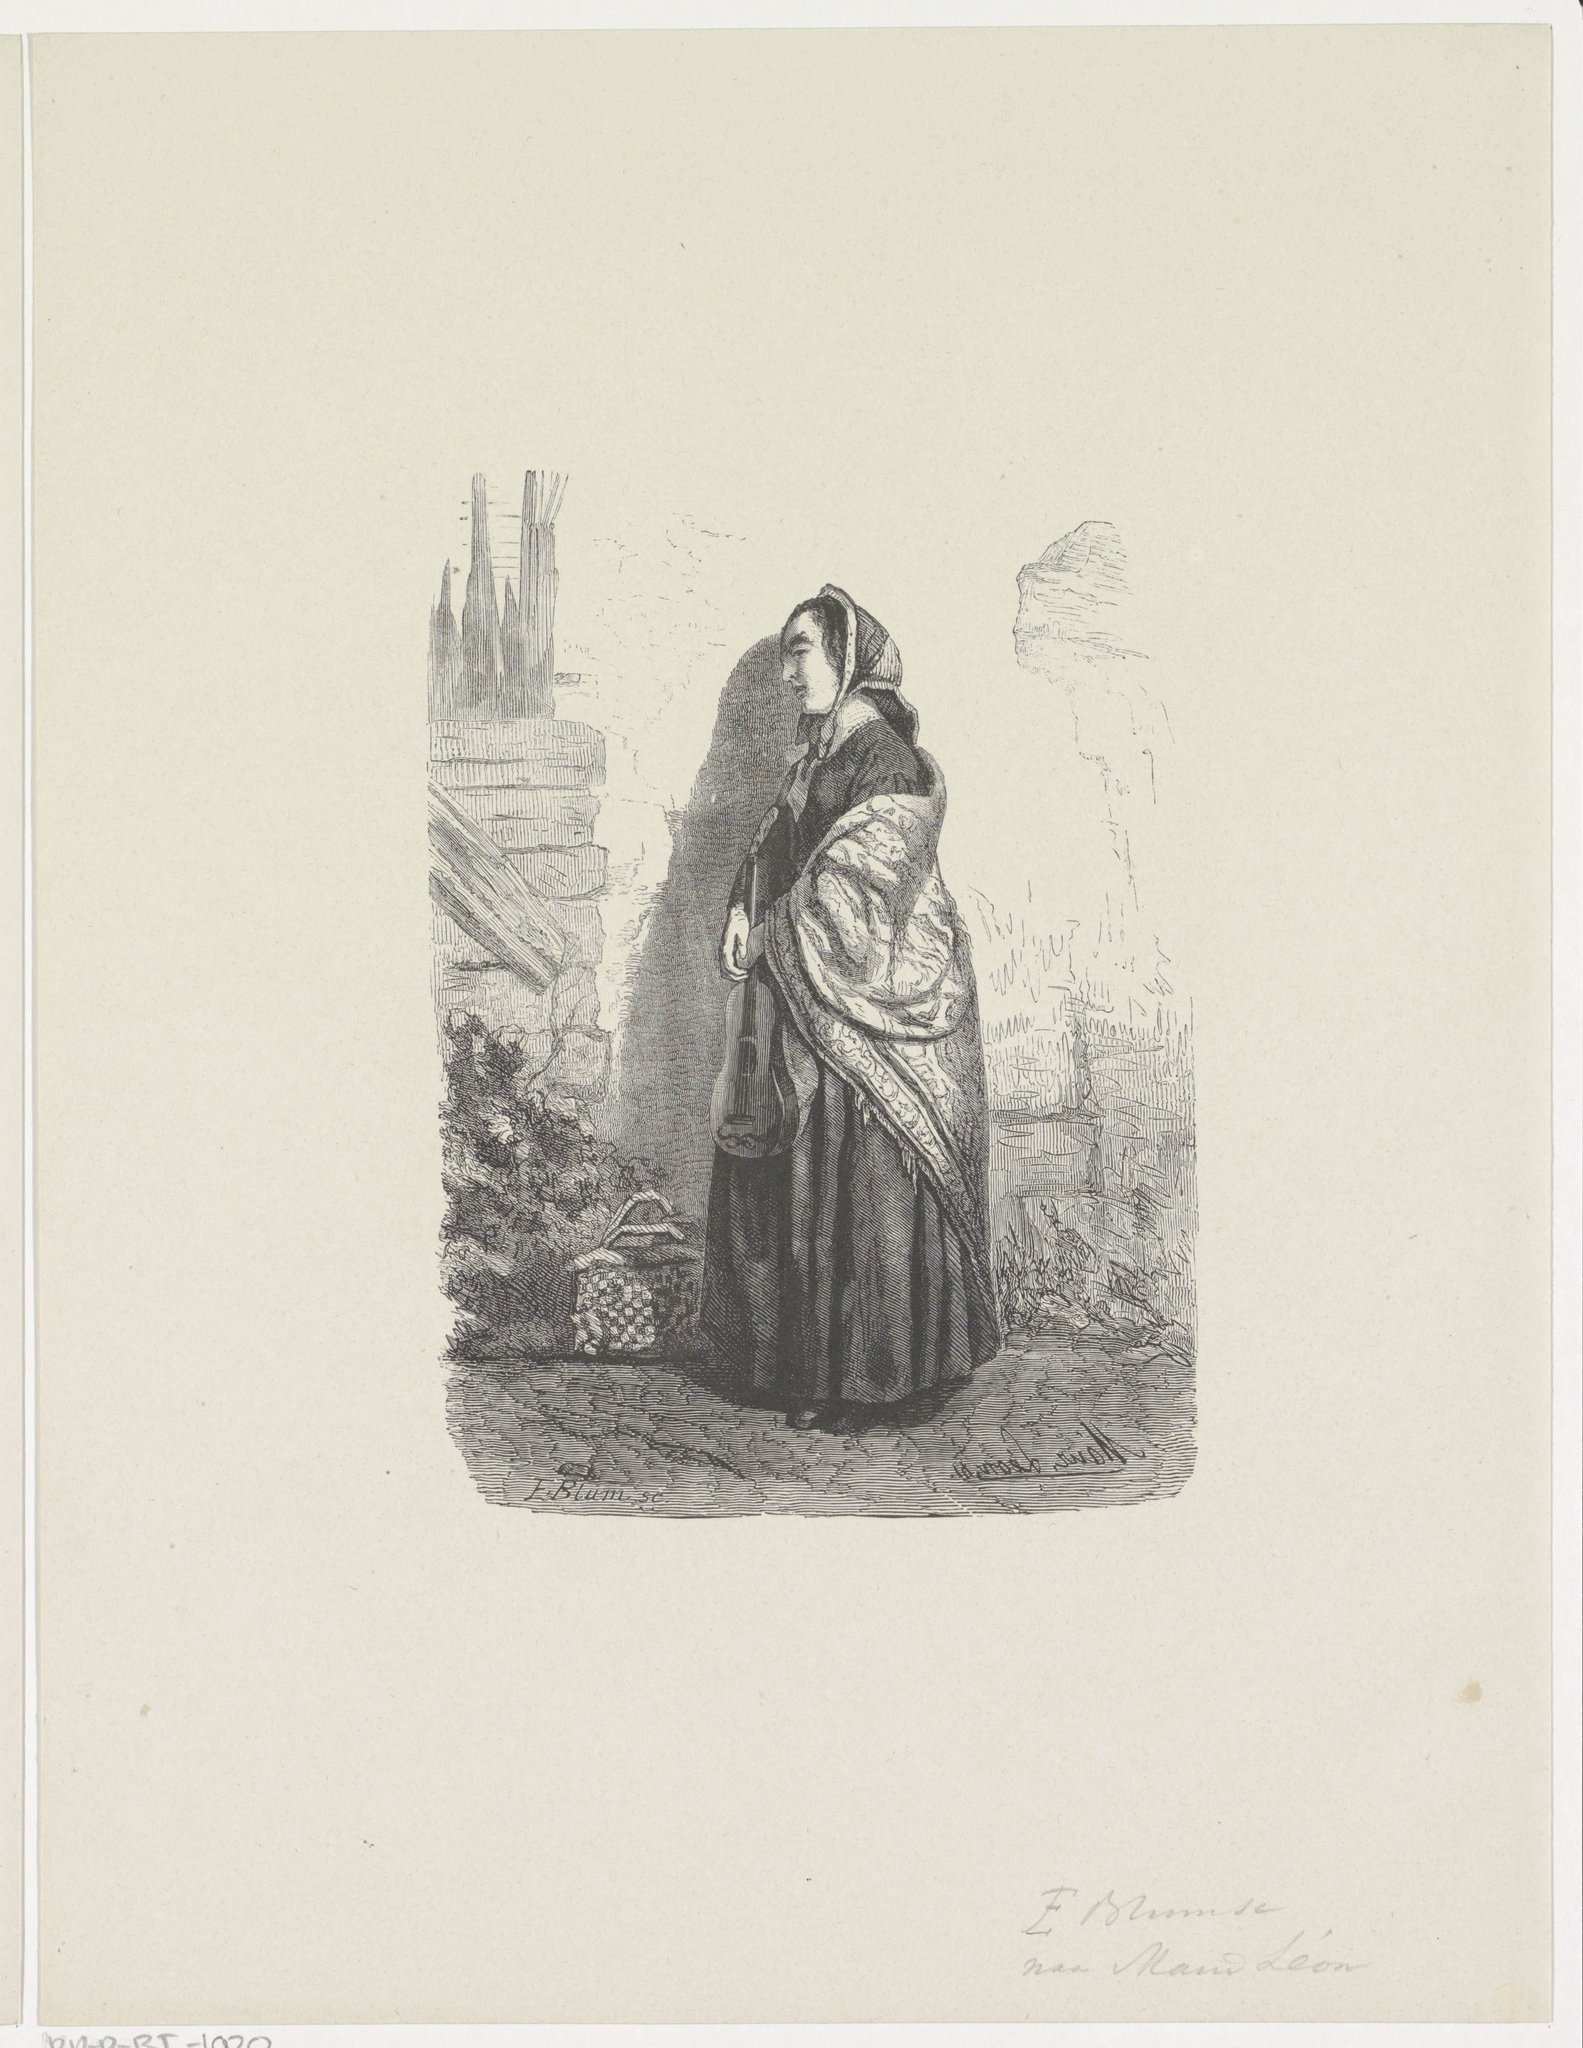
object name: print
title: Vrouw met een gitaar leunend tegen een muur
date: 1848-1865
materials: paper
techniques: engraving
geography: netherlands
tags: cithern, mandolin, guitar, balalaika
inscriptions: collector's mark: Lugt 2228